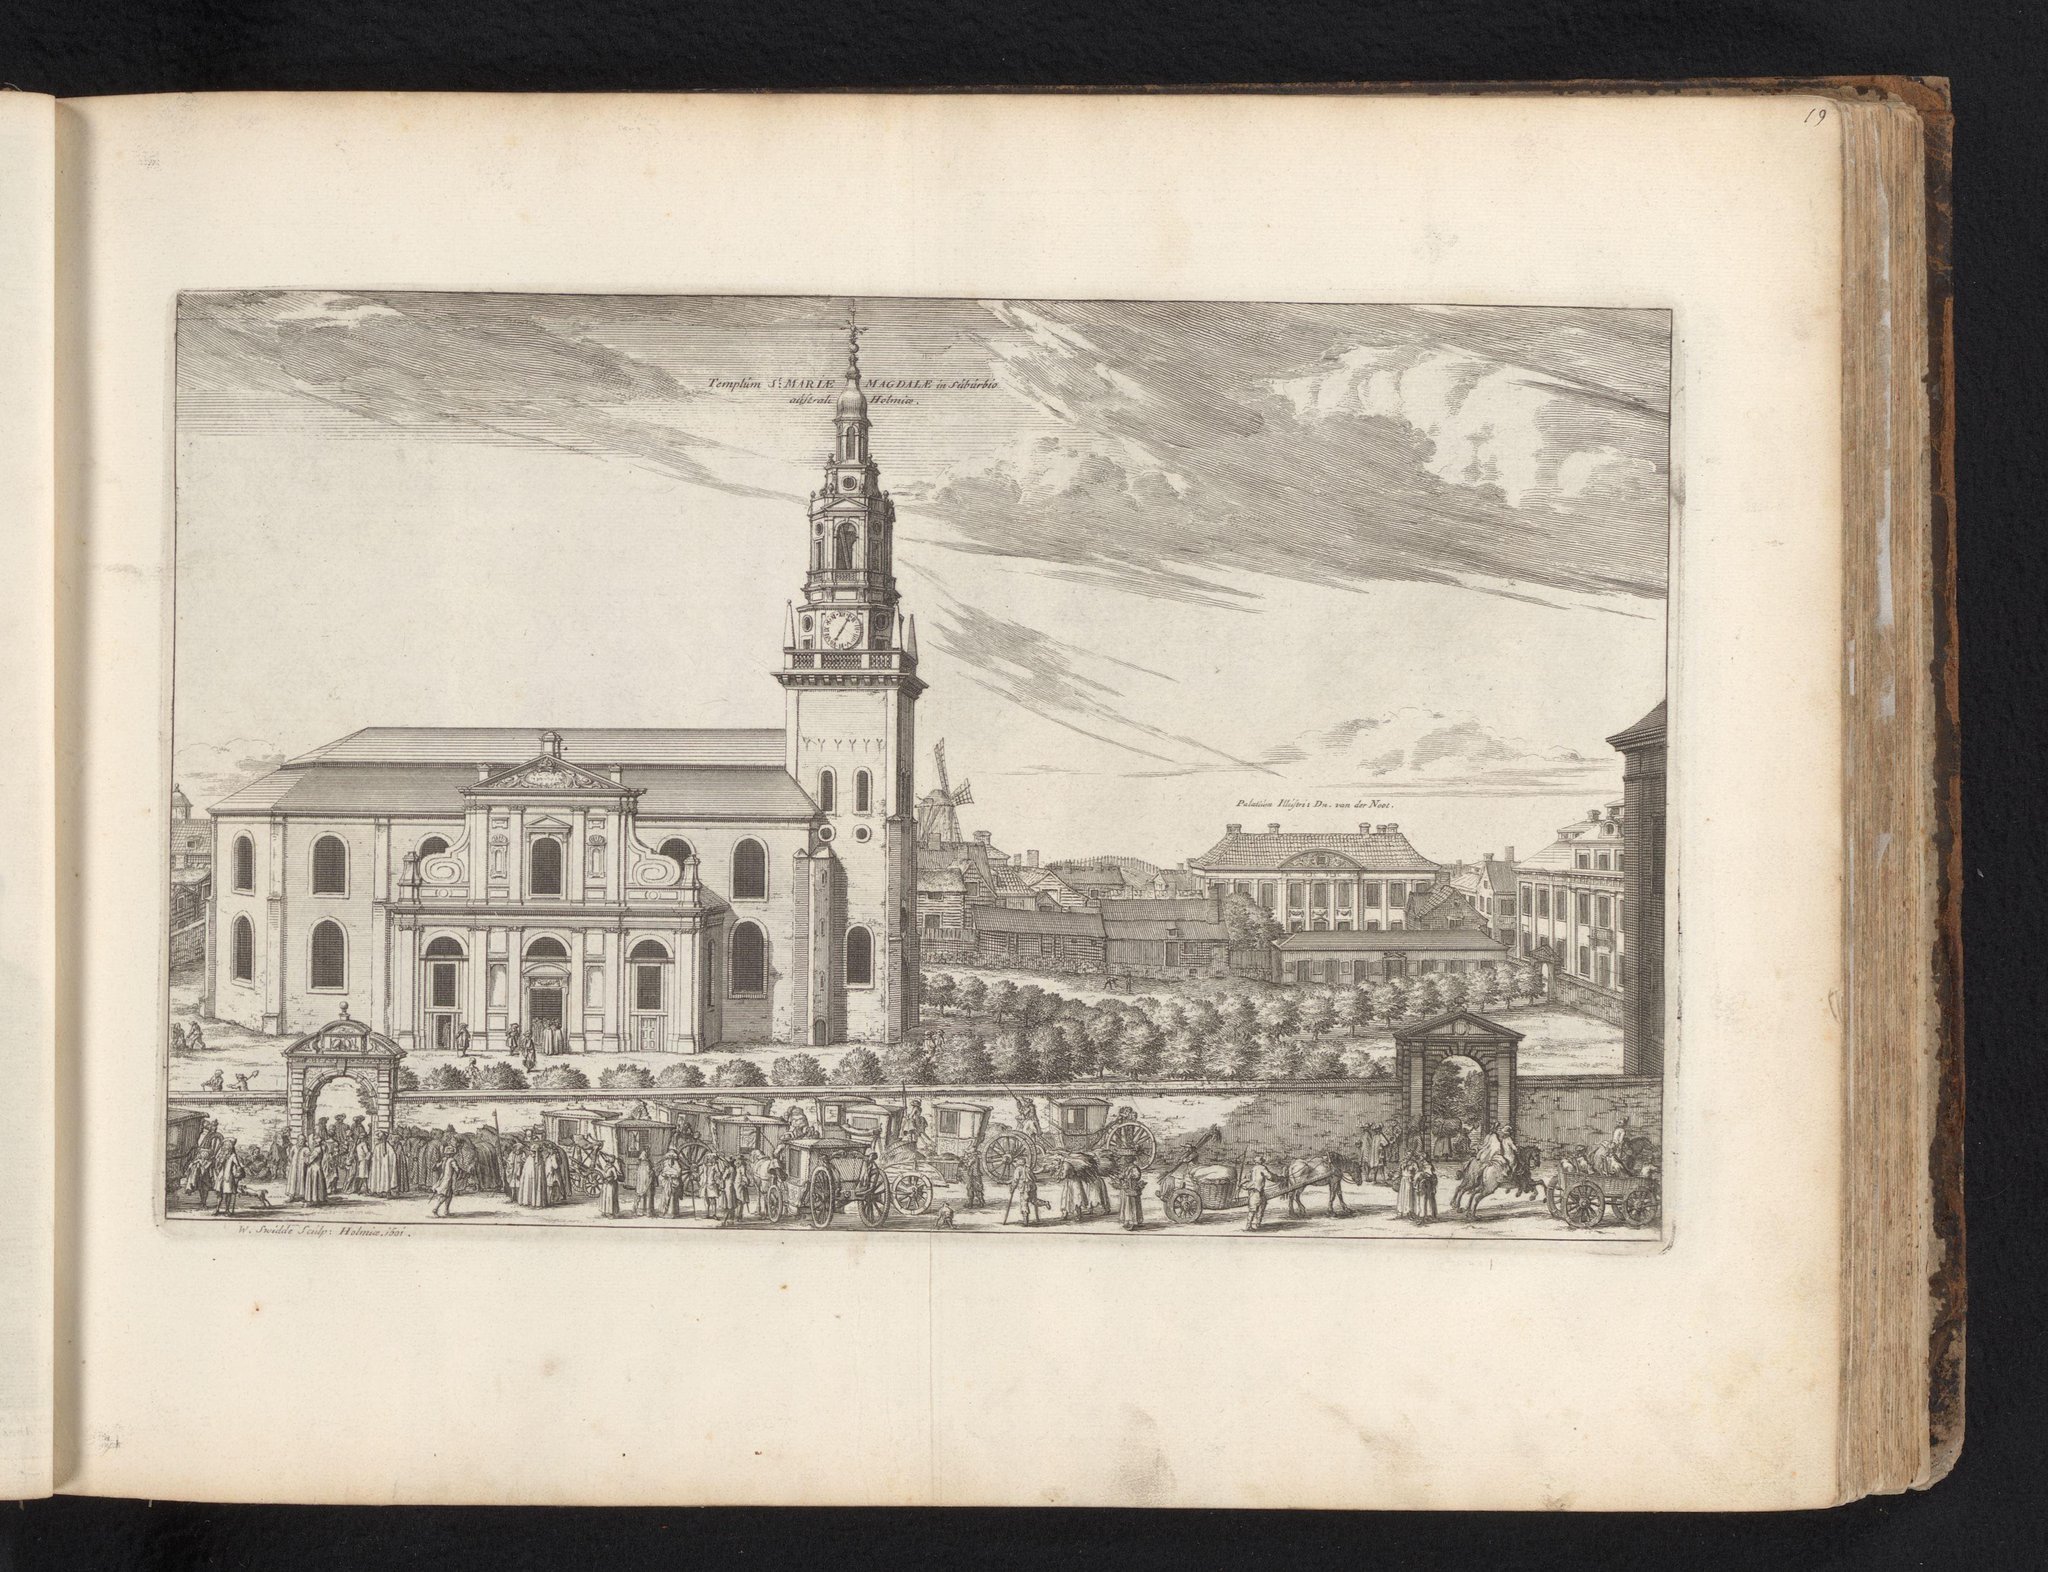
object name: album leaf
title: Gezicht op de Maria Magdalenakerk in Stockholm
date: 1691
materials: paper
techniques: etching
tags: traffic on land, church (exterior)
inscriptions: date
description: De Maria Magdalenakerk in Stockholm. Op de voorgrond verschillende rijtuigen en koetsen. De prent maakt deel uit van een album.